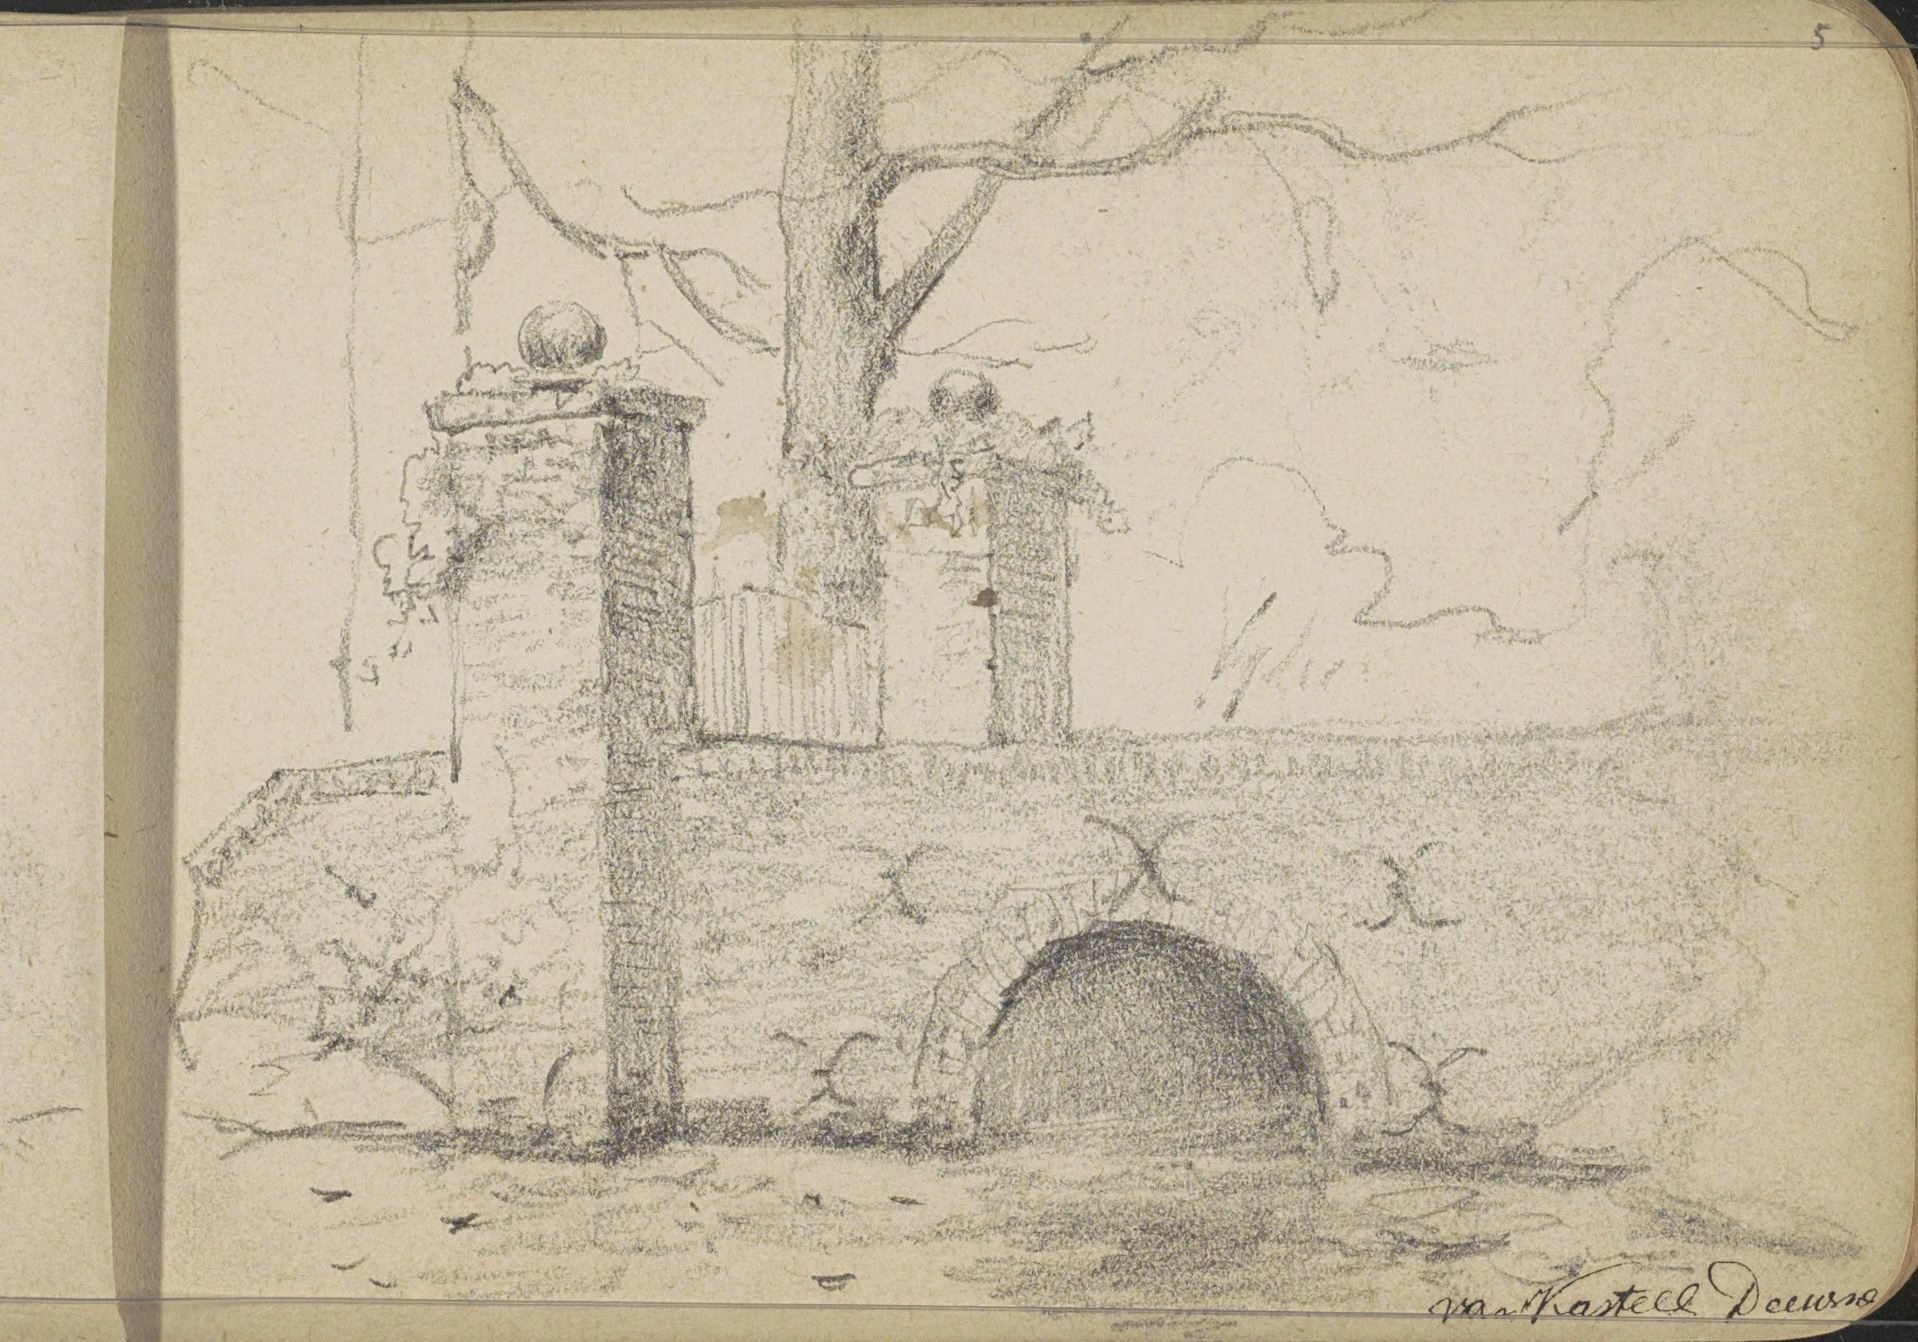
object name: sketchbook leaf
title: Brug naar het Groot Kasteel te Deurne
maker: willem cornelis rip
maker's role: draughtsman, painter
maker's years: 1856-1922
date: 1896-1897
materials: paper, pencil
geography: deurne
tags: bridge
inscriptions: annotation: ‘naar Kasteel Deurne’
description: Blad 5 recto uit een schetsboek met 44 bladen.